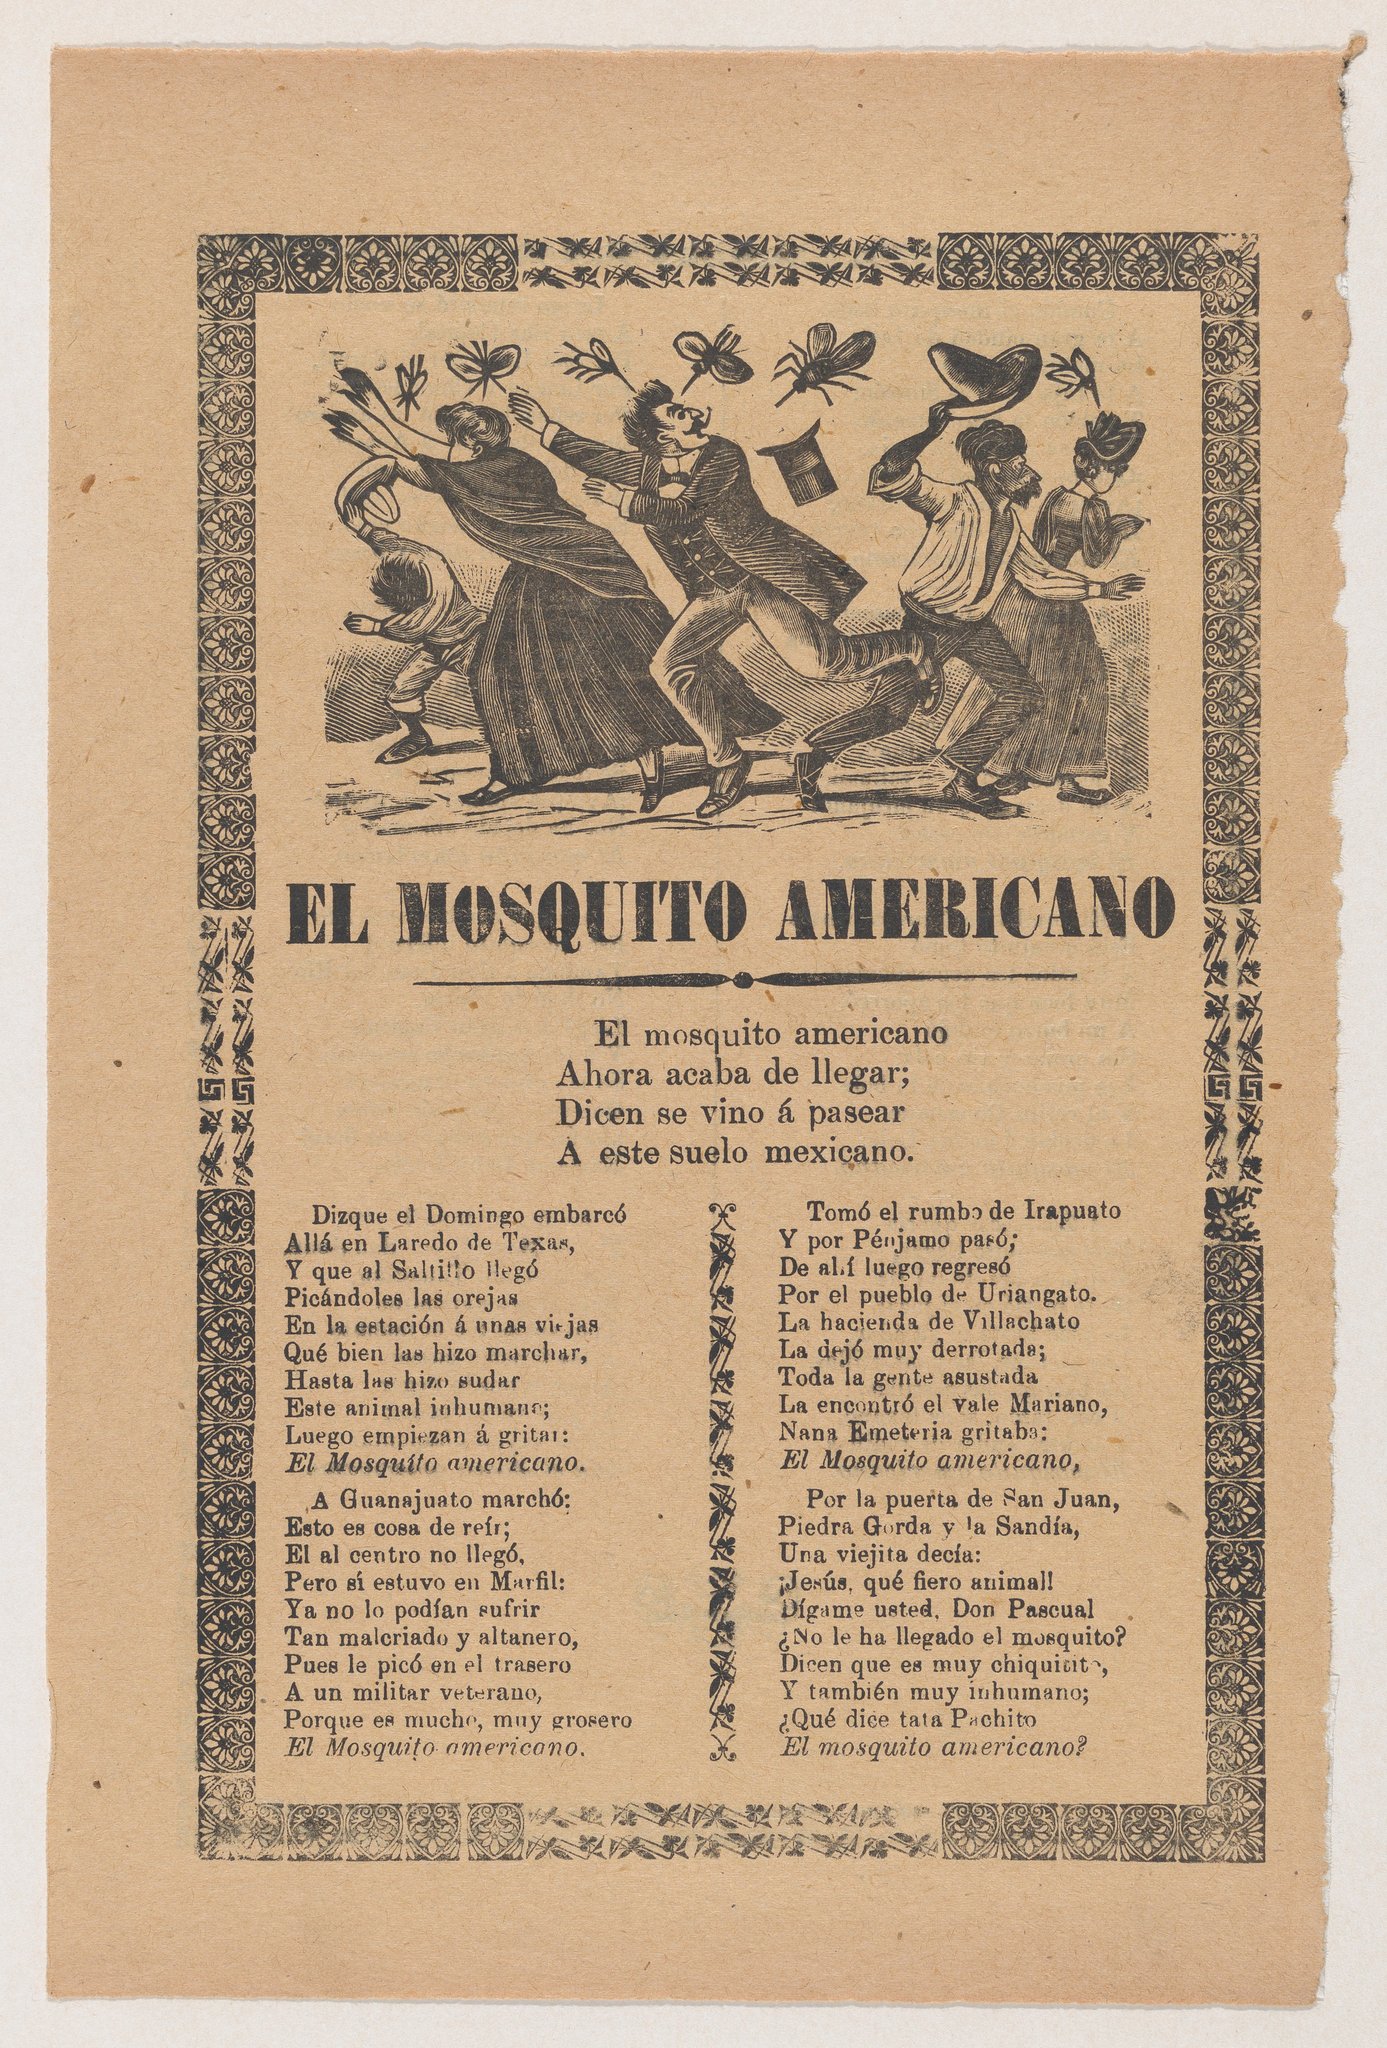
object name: print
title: Broadsheet relating to the American Mosquito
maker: josé guadalupe posada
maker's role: artist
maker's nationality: mexican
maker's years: 1852-1913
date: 1903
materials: metal, paper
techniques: engraving, letterpress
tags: men,women,insects